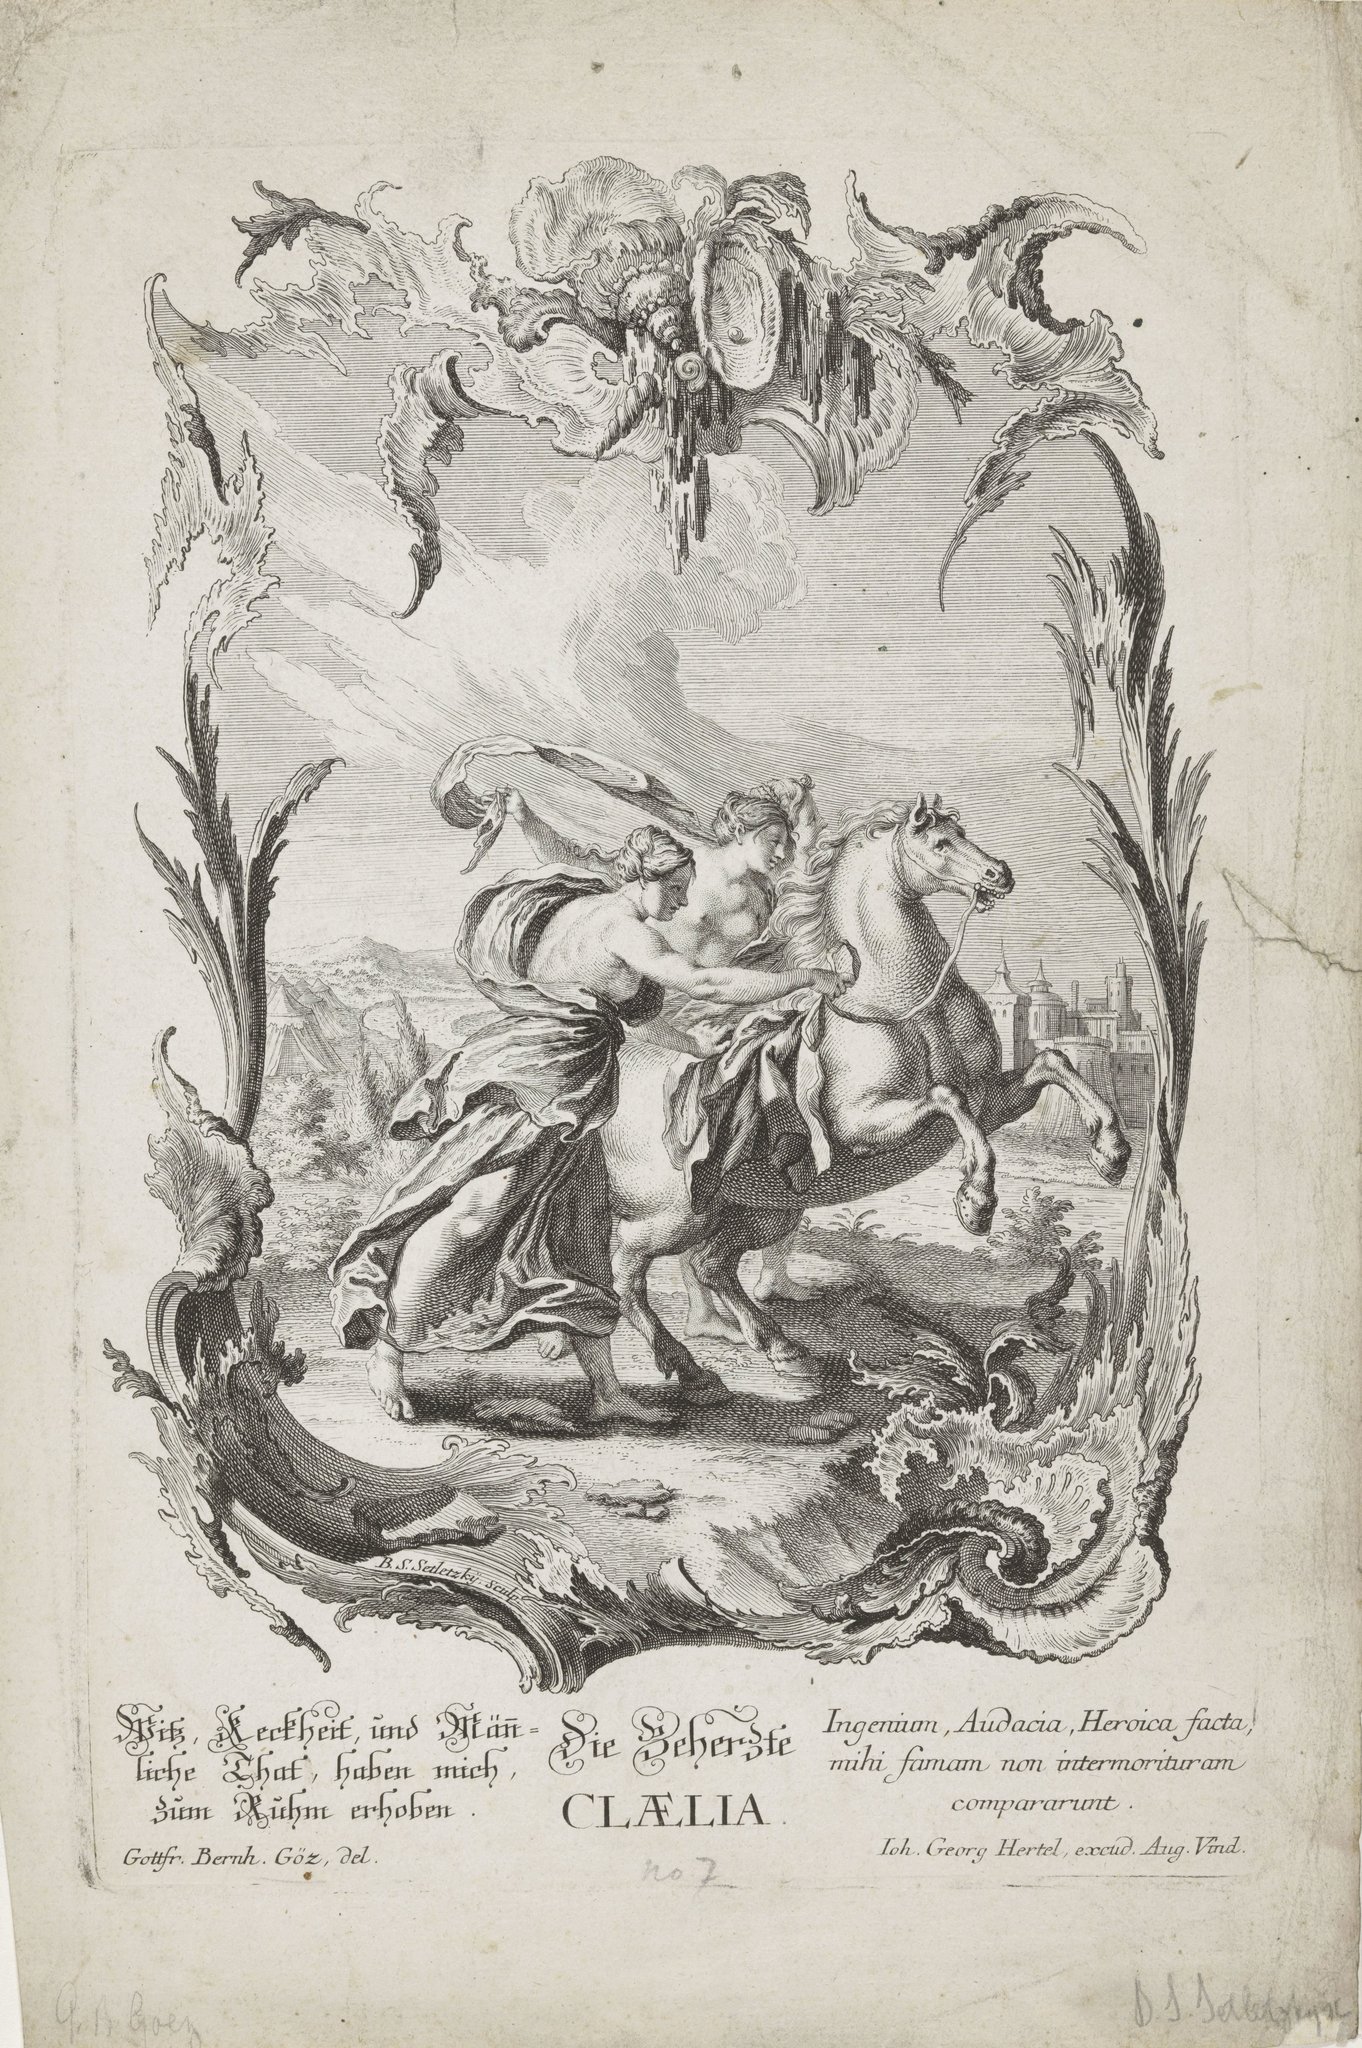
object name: ornament print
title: De moedige Cloelia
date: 1730-1770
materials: paper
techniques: engraving, etching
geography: augsburg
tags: rocaille ornament, (story of) cloelia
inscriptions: collector's mark: Lugt 2233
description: Cloelia en twee vrouwen staan met een paard langs de Tiber. In de ondermarge twee maal een drieregelige tekst in het Duits en Latijn.